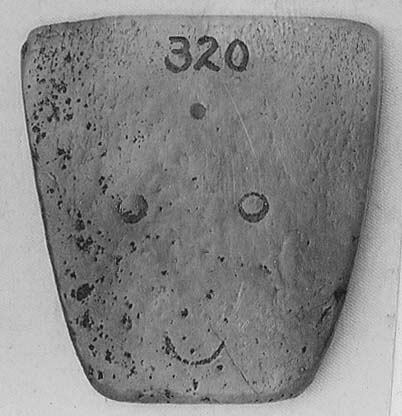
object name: celt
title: Archaic Celt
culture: chinese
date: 206 BCE-220 CE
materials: jade